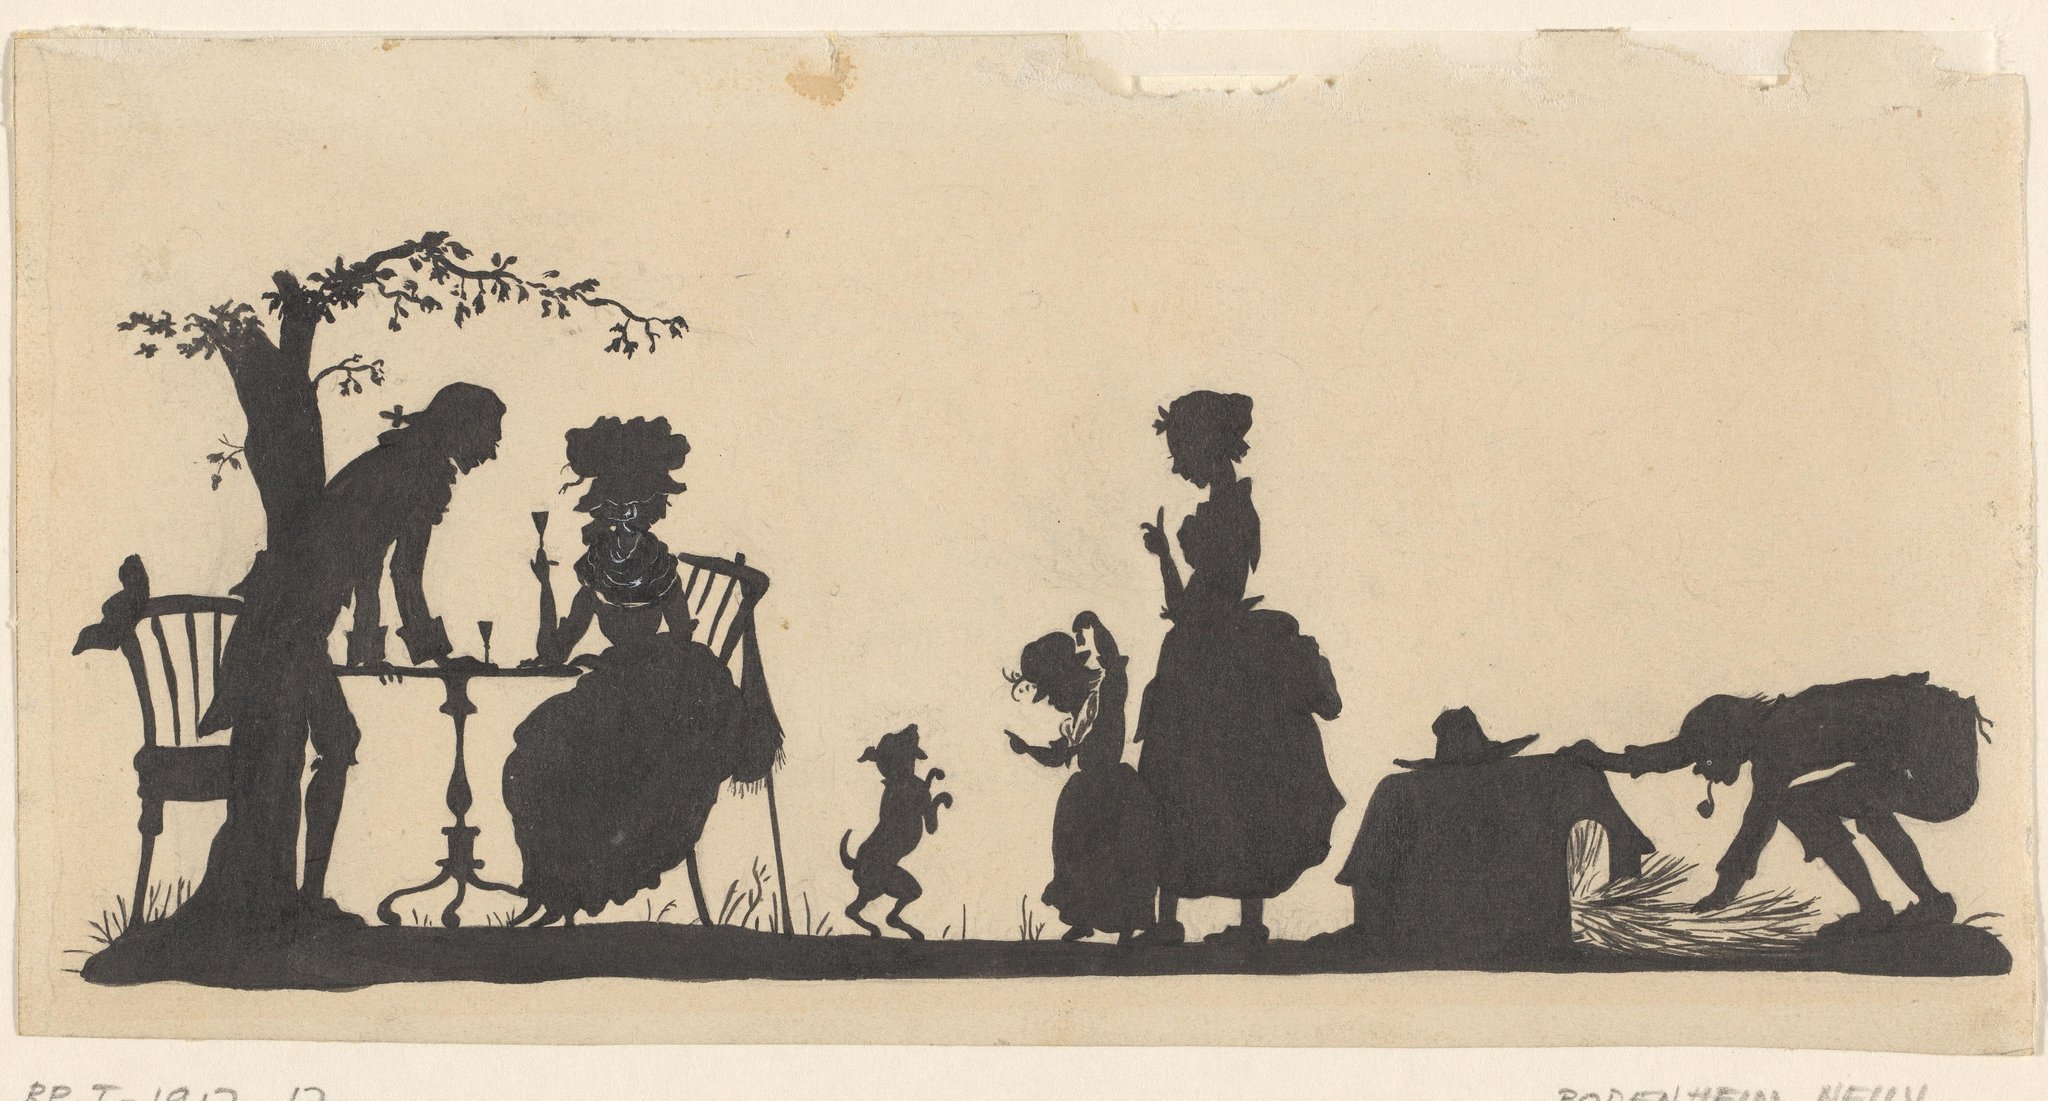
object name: drawing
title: Ontwerp voor In Holland staat een Huis: silhouet van een familie in de tuin, met de meid en tuinman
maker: nelly bodenheim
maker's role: designer, draughtsman, print maker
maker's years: 1874-1951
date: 1884-1917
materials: paper, pencil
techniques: brush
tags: 83(van looy, in holland staat een huis)